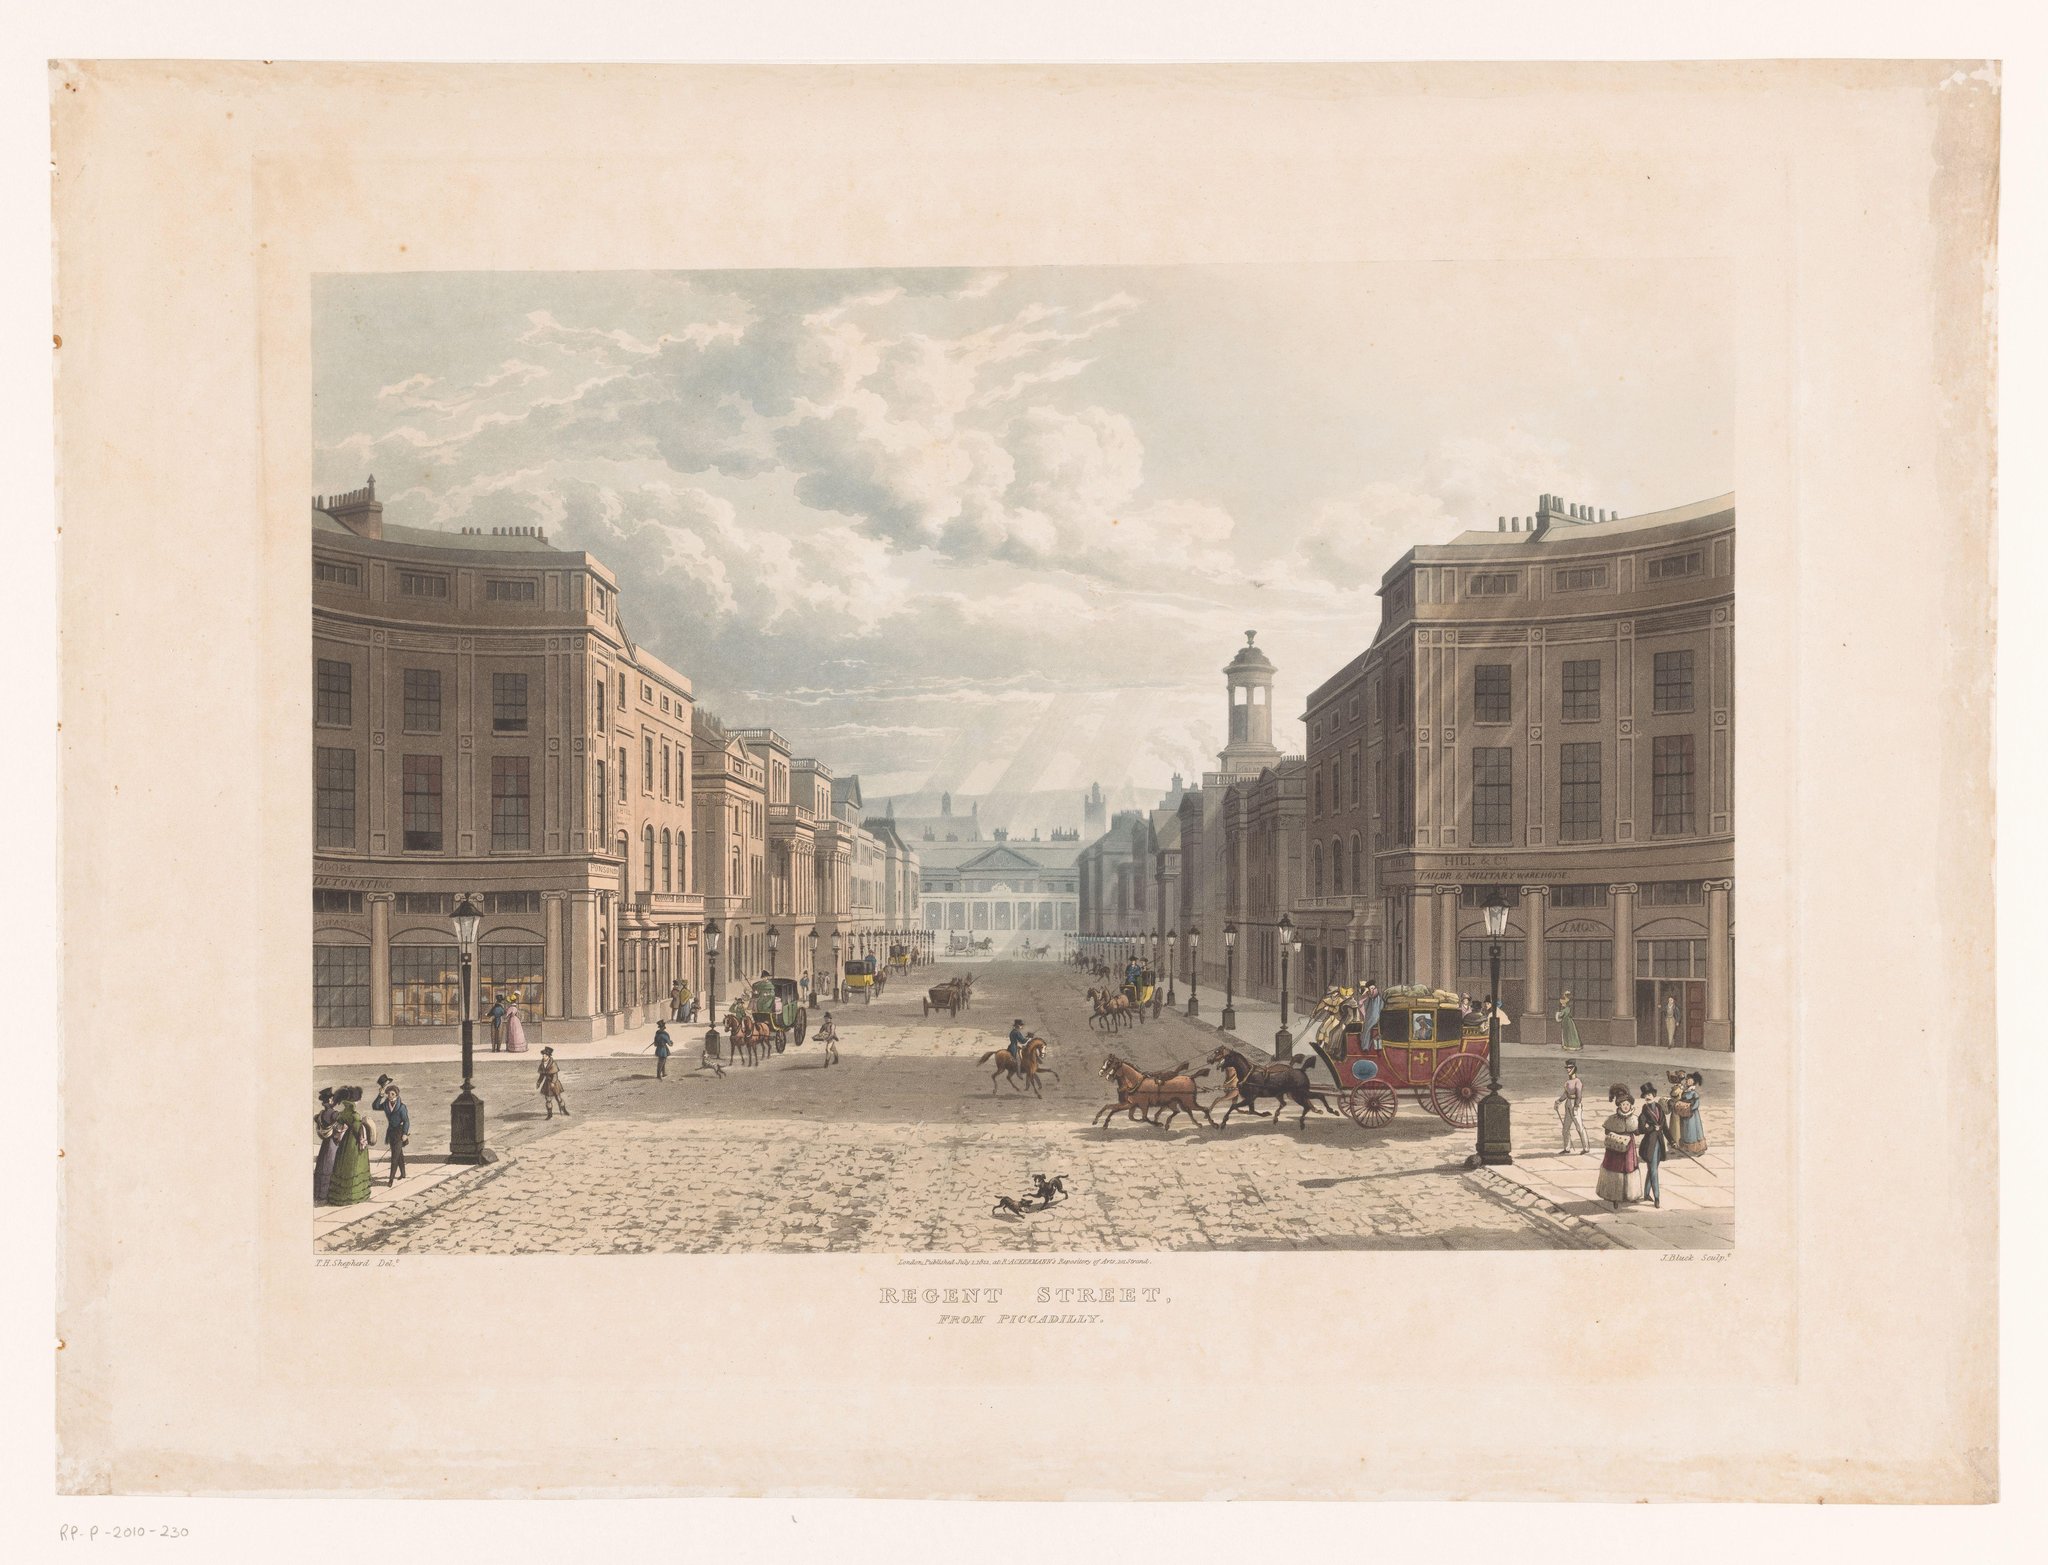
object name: print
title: Gezicht op Regent Street, Londen vanaf Picadilly Circus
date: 1822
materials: ink, paper, watercolor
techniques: etching, hand coloring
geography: england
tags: street (+ city(-scape) with figures, staffage), london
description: Gezicht op Regent Street, Londen vanaf Picadilly Circus met wandelaars en rijtuigen. Ingekleurde aquatint in originele lijst.